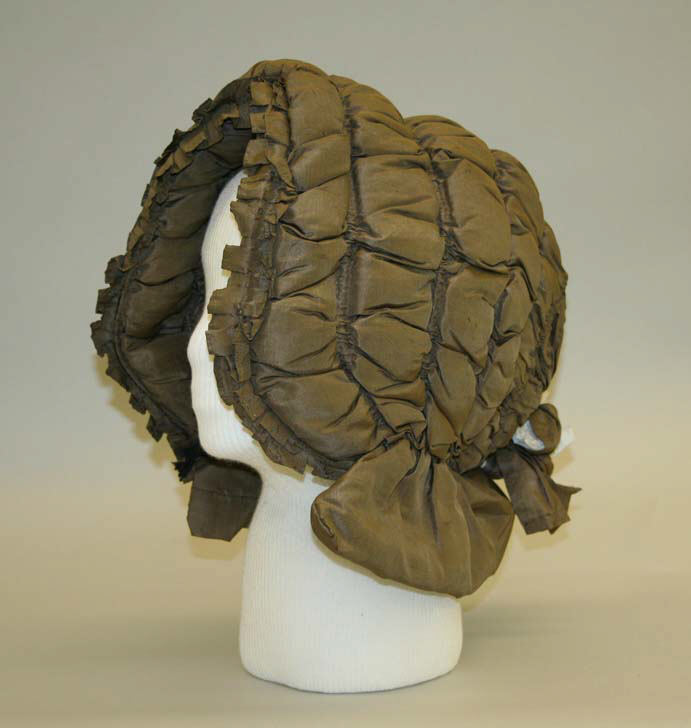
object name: bonnet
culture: american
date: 1801-1833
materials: silk